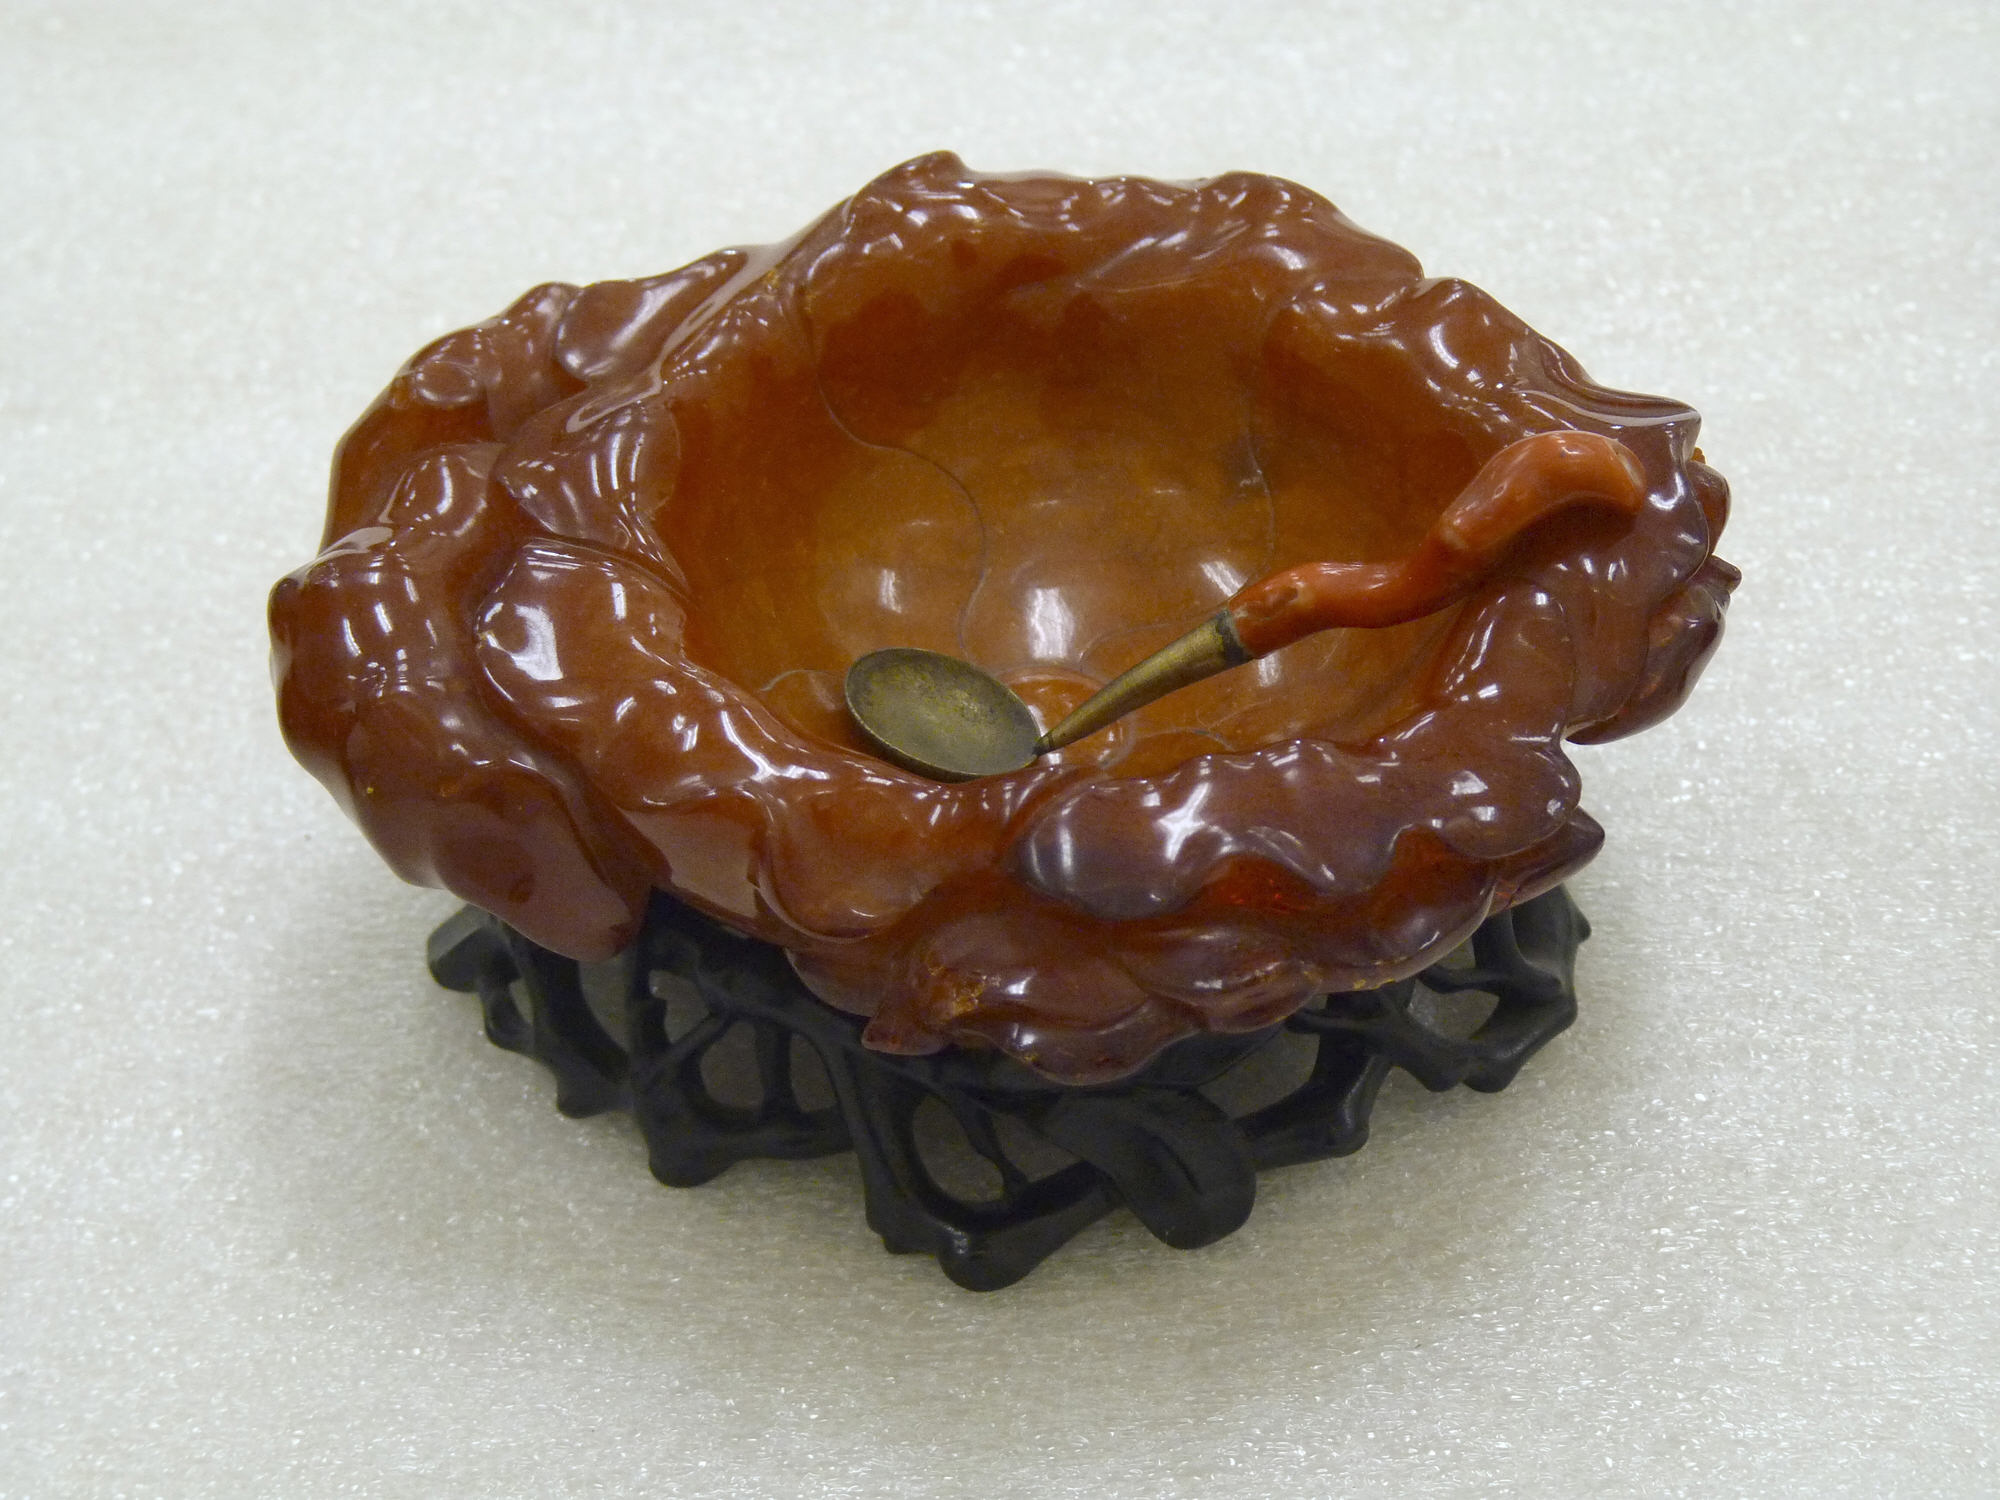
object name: dish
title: Dish with Floral Design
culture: chinese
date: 1644-1911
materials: amber